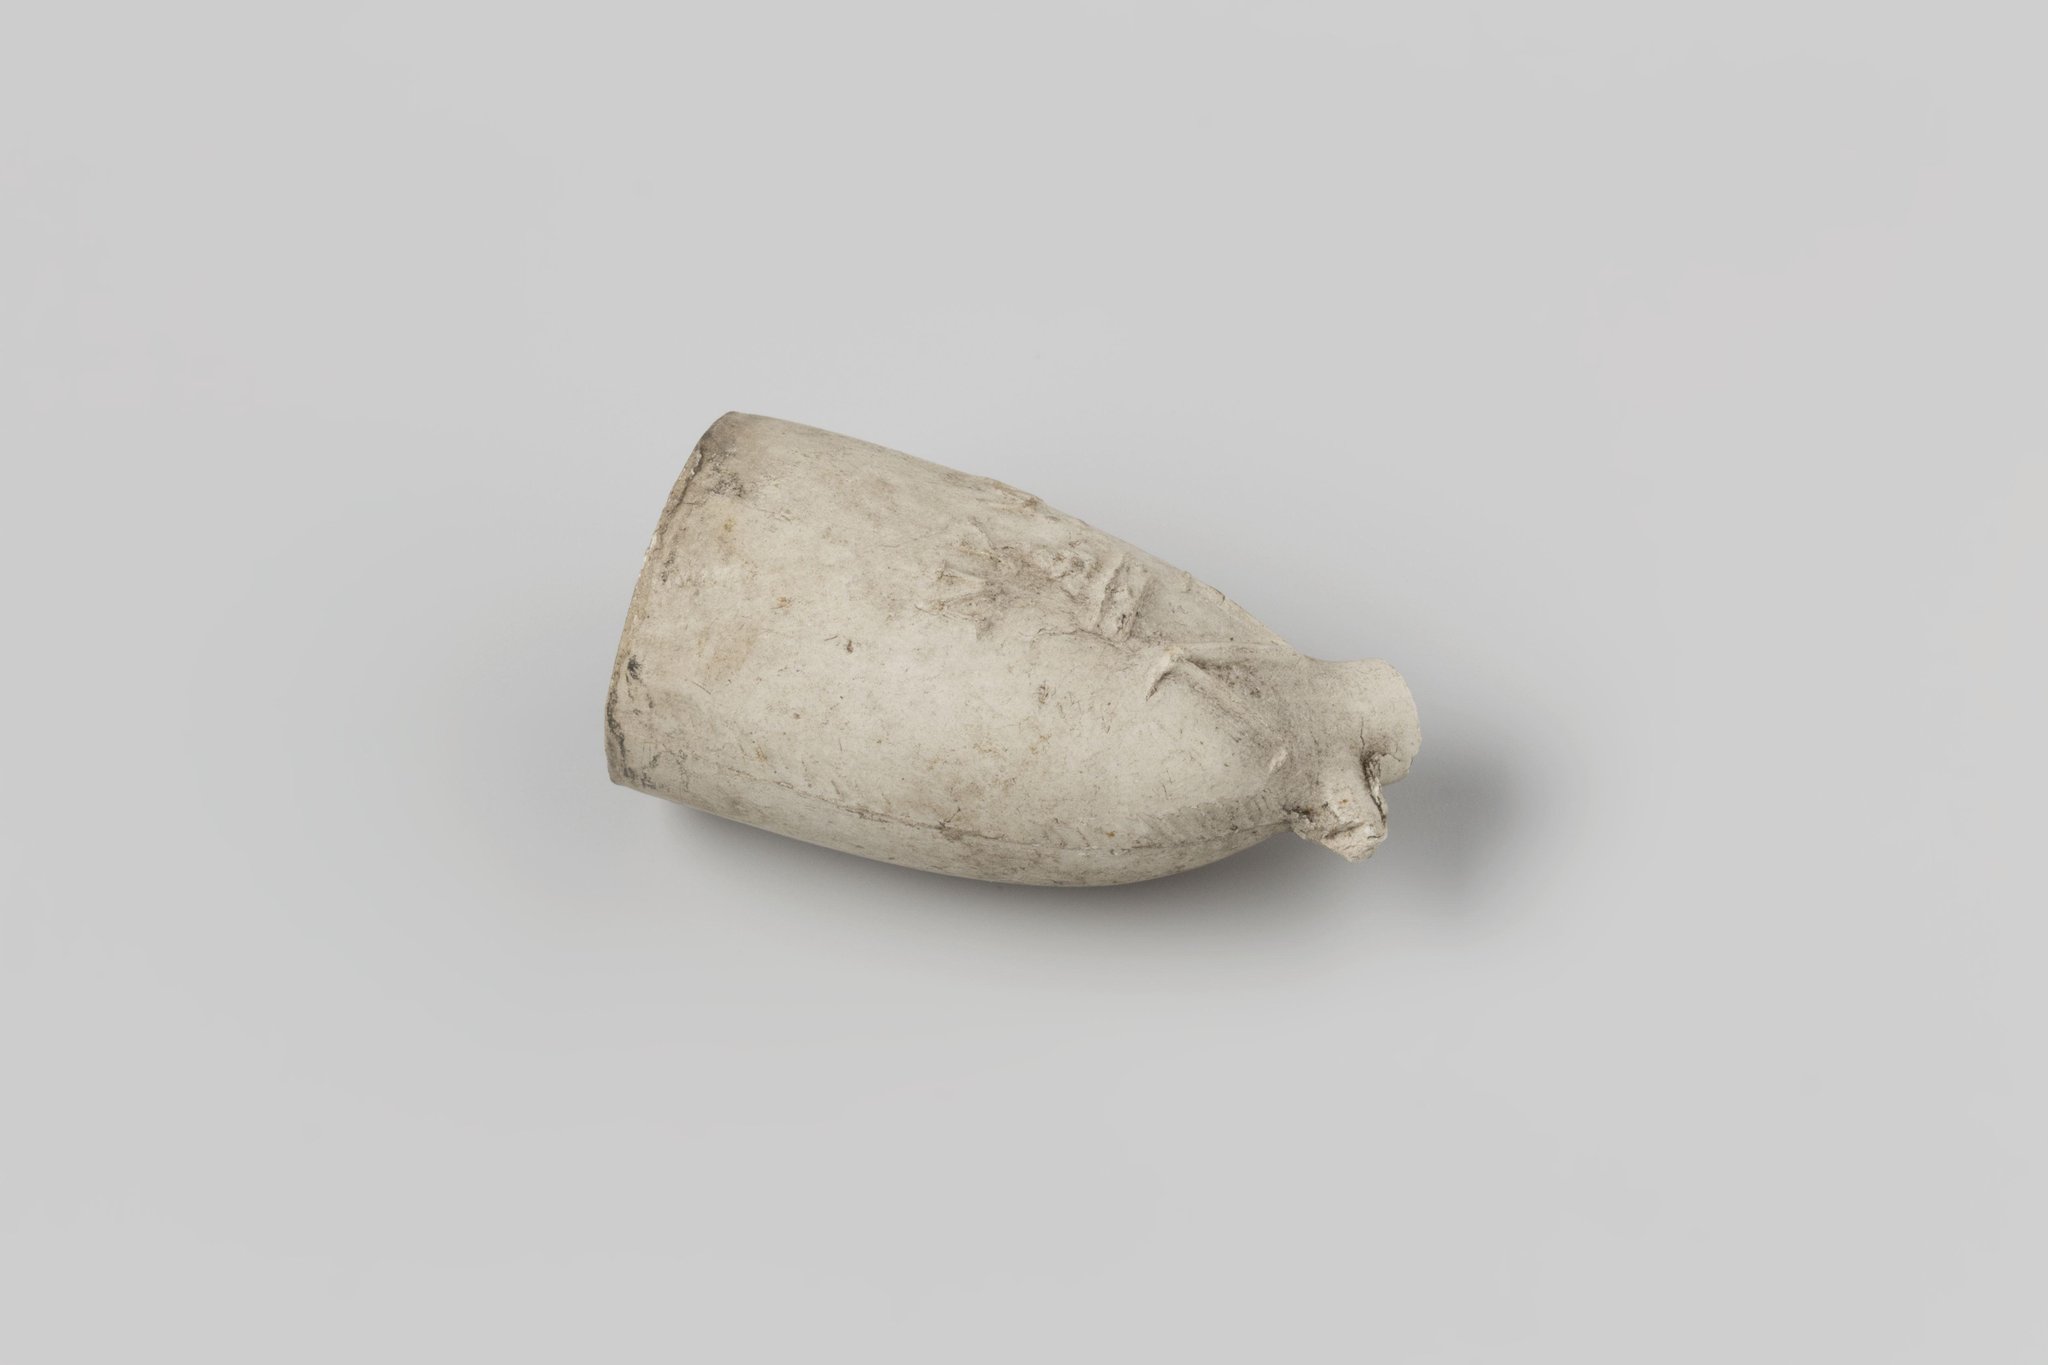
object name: pipe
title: Fragment pijpenkop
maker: nicolaas walter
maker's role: pijpenfabrikant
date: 1790-1794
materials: clay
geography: schoonhoven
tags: the hague, rotterdam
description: Fragment pijpenkop met de letters N K W met gekroonde N afgebeeld. Van de opgravingen op de Hofstede Arentsburg 1827-1831 onder toezicht van Professor Reuvens.